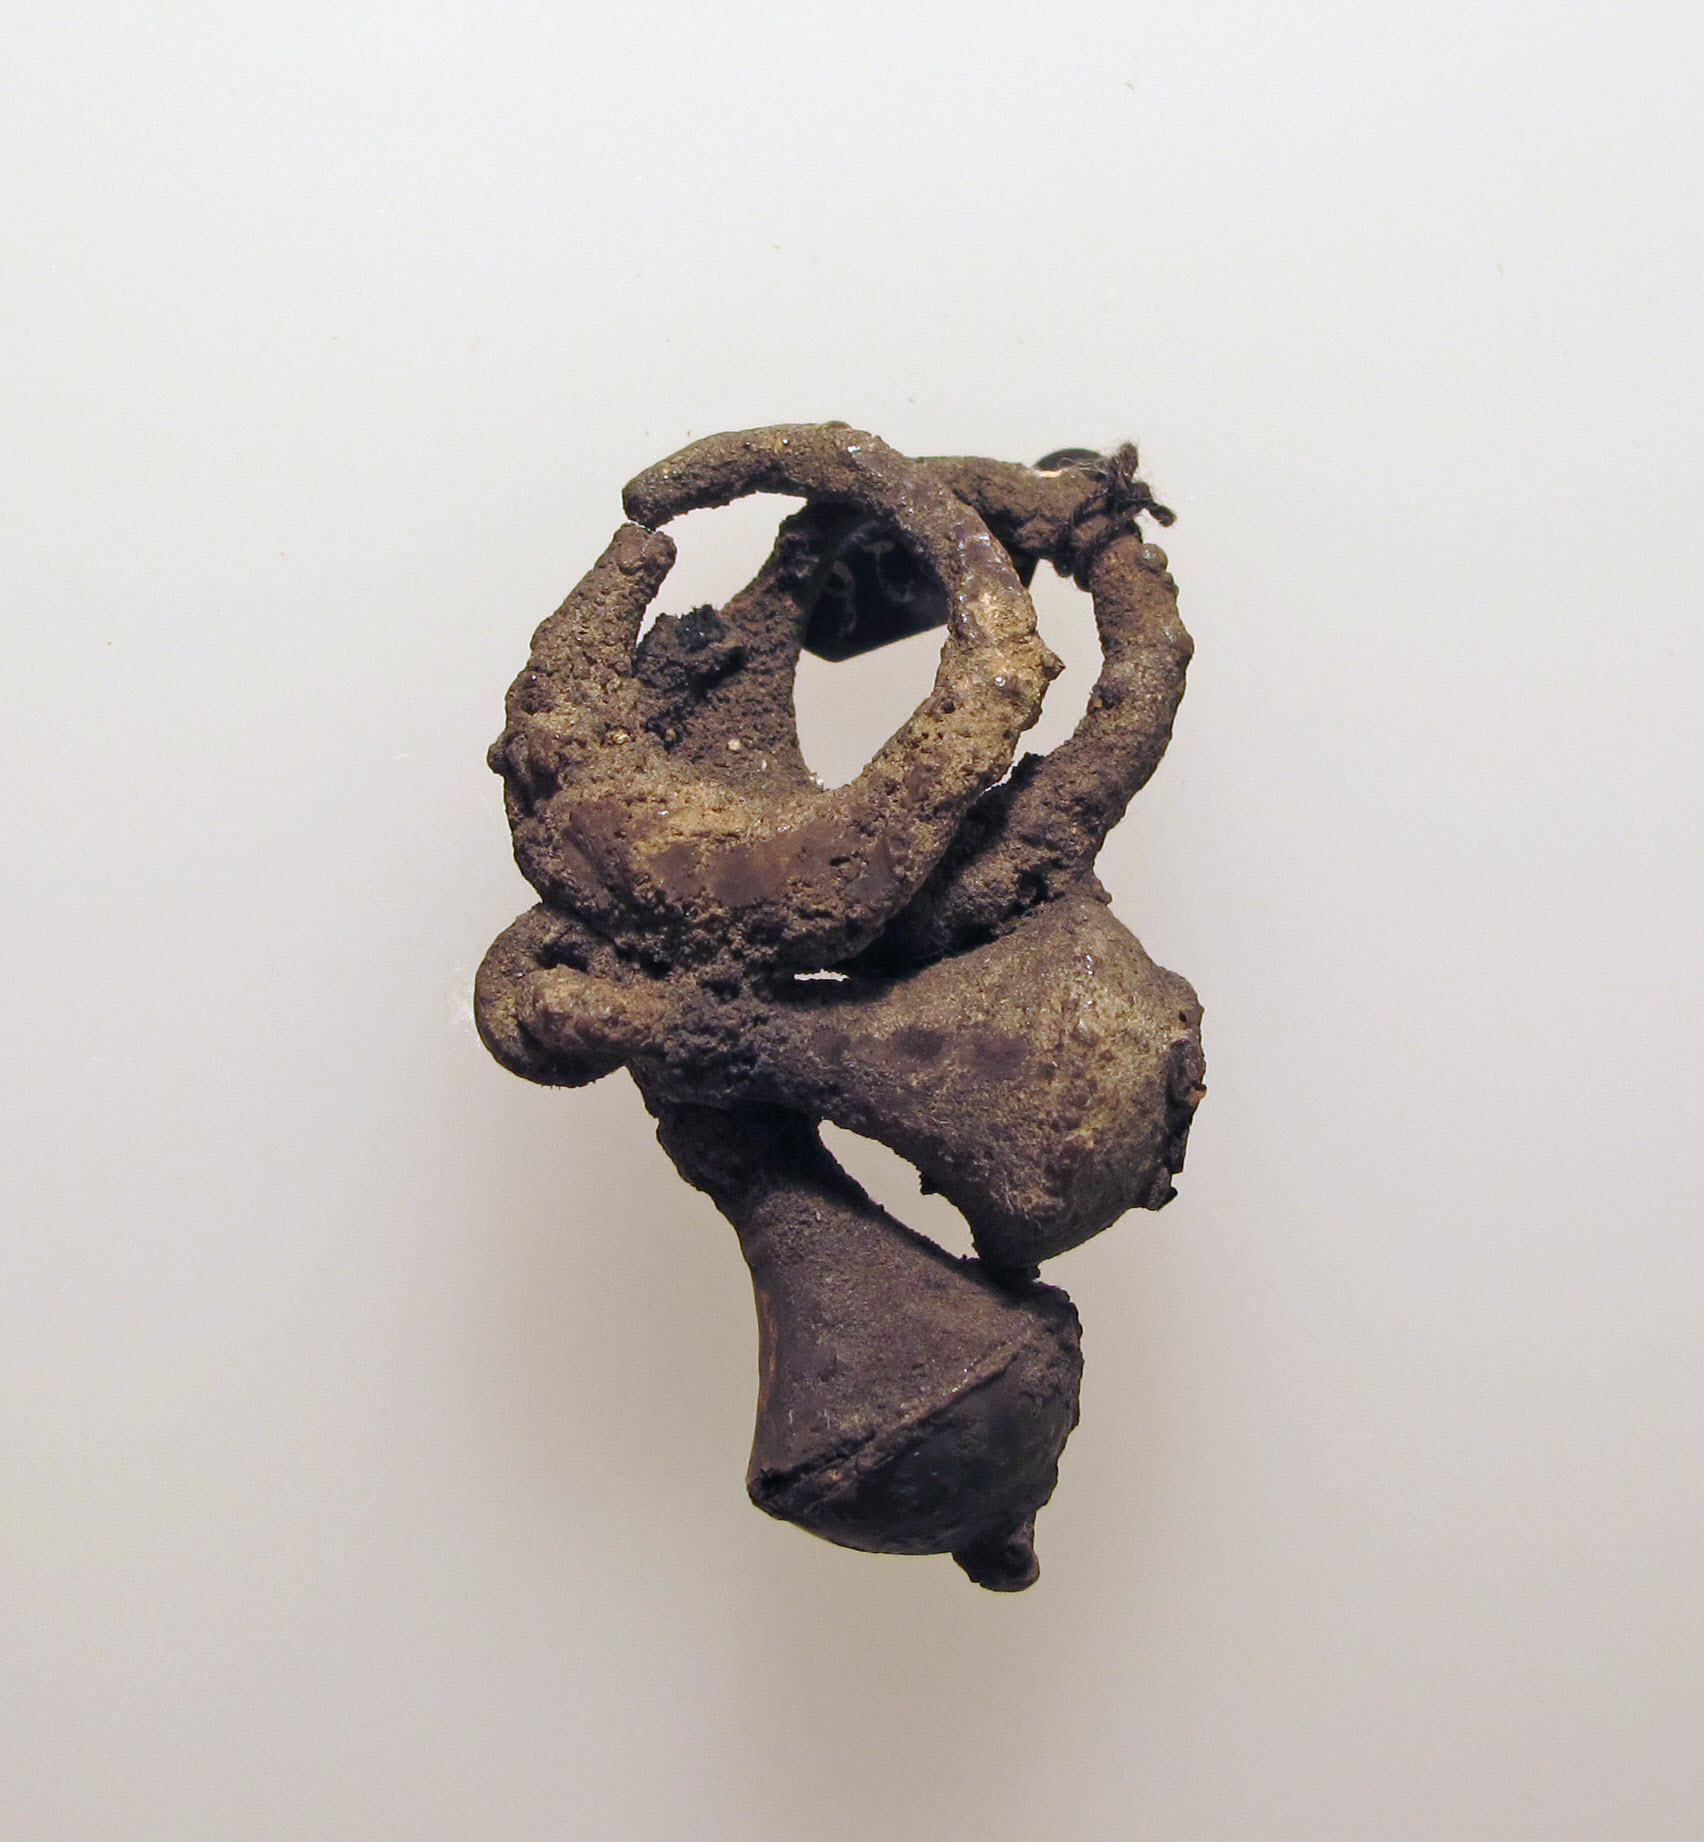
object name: earring with nail head pendant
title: Two silver earrings with nail head pendants, corroded together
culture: cypriot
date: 3900 BCE-100 CE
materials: silver